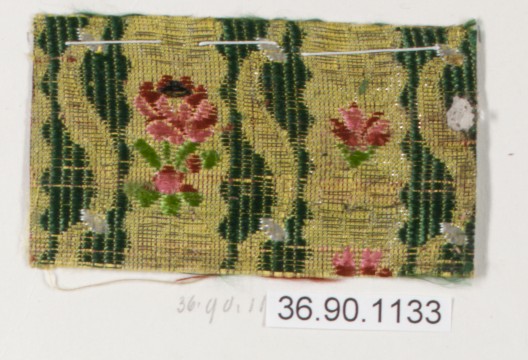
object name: sample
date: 1701-1900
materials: metal thread, silk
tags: flowers